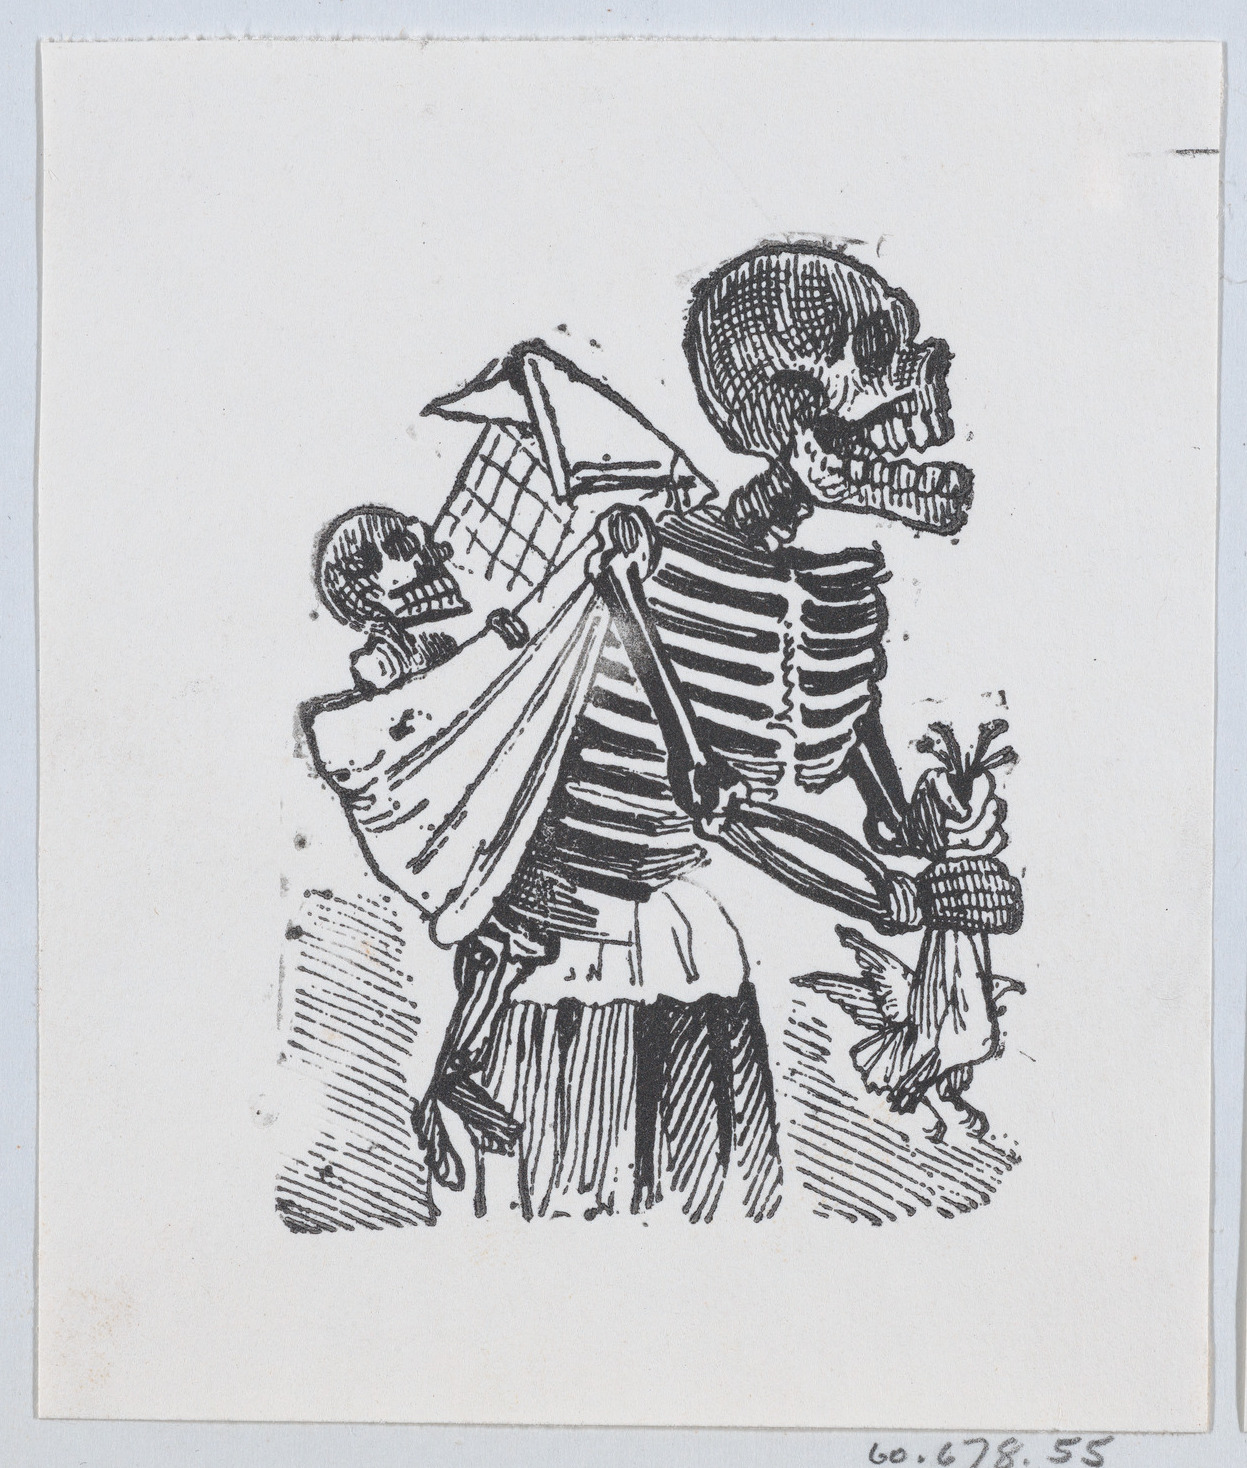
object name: print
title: A skeleton picking crops in a field while carrying a baby skeleton on its back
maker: josé guadalupe posada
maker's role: artist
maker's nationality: mexican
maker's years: 1852-1913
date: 1880-1910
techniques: lithography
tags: skeletons